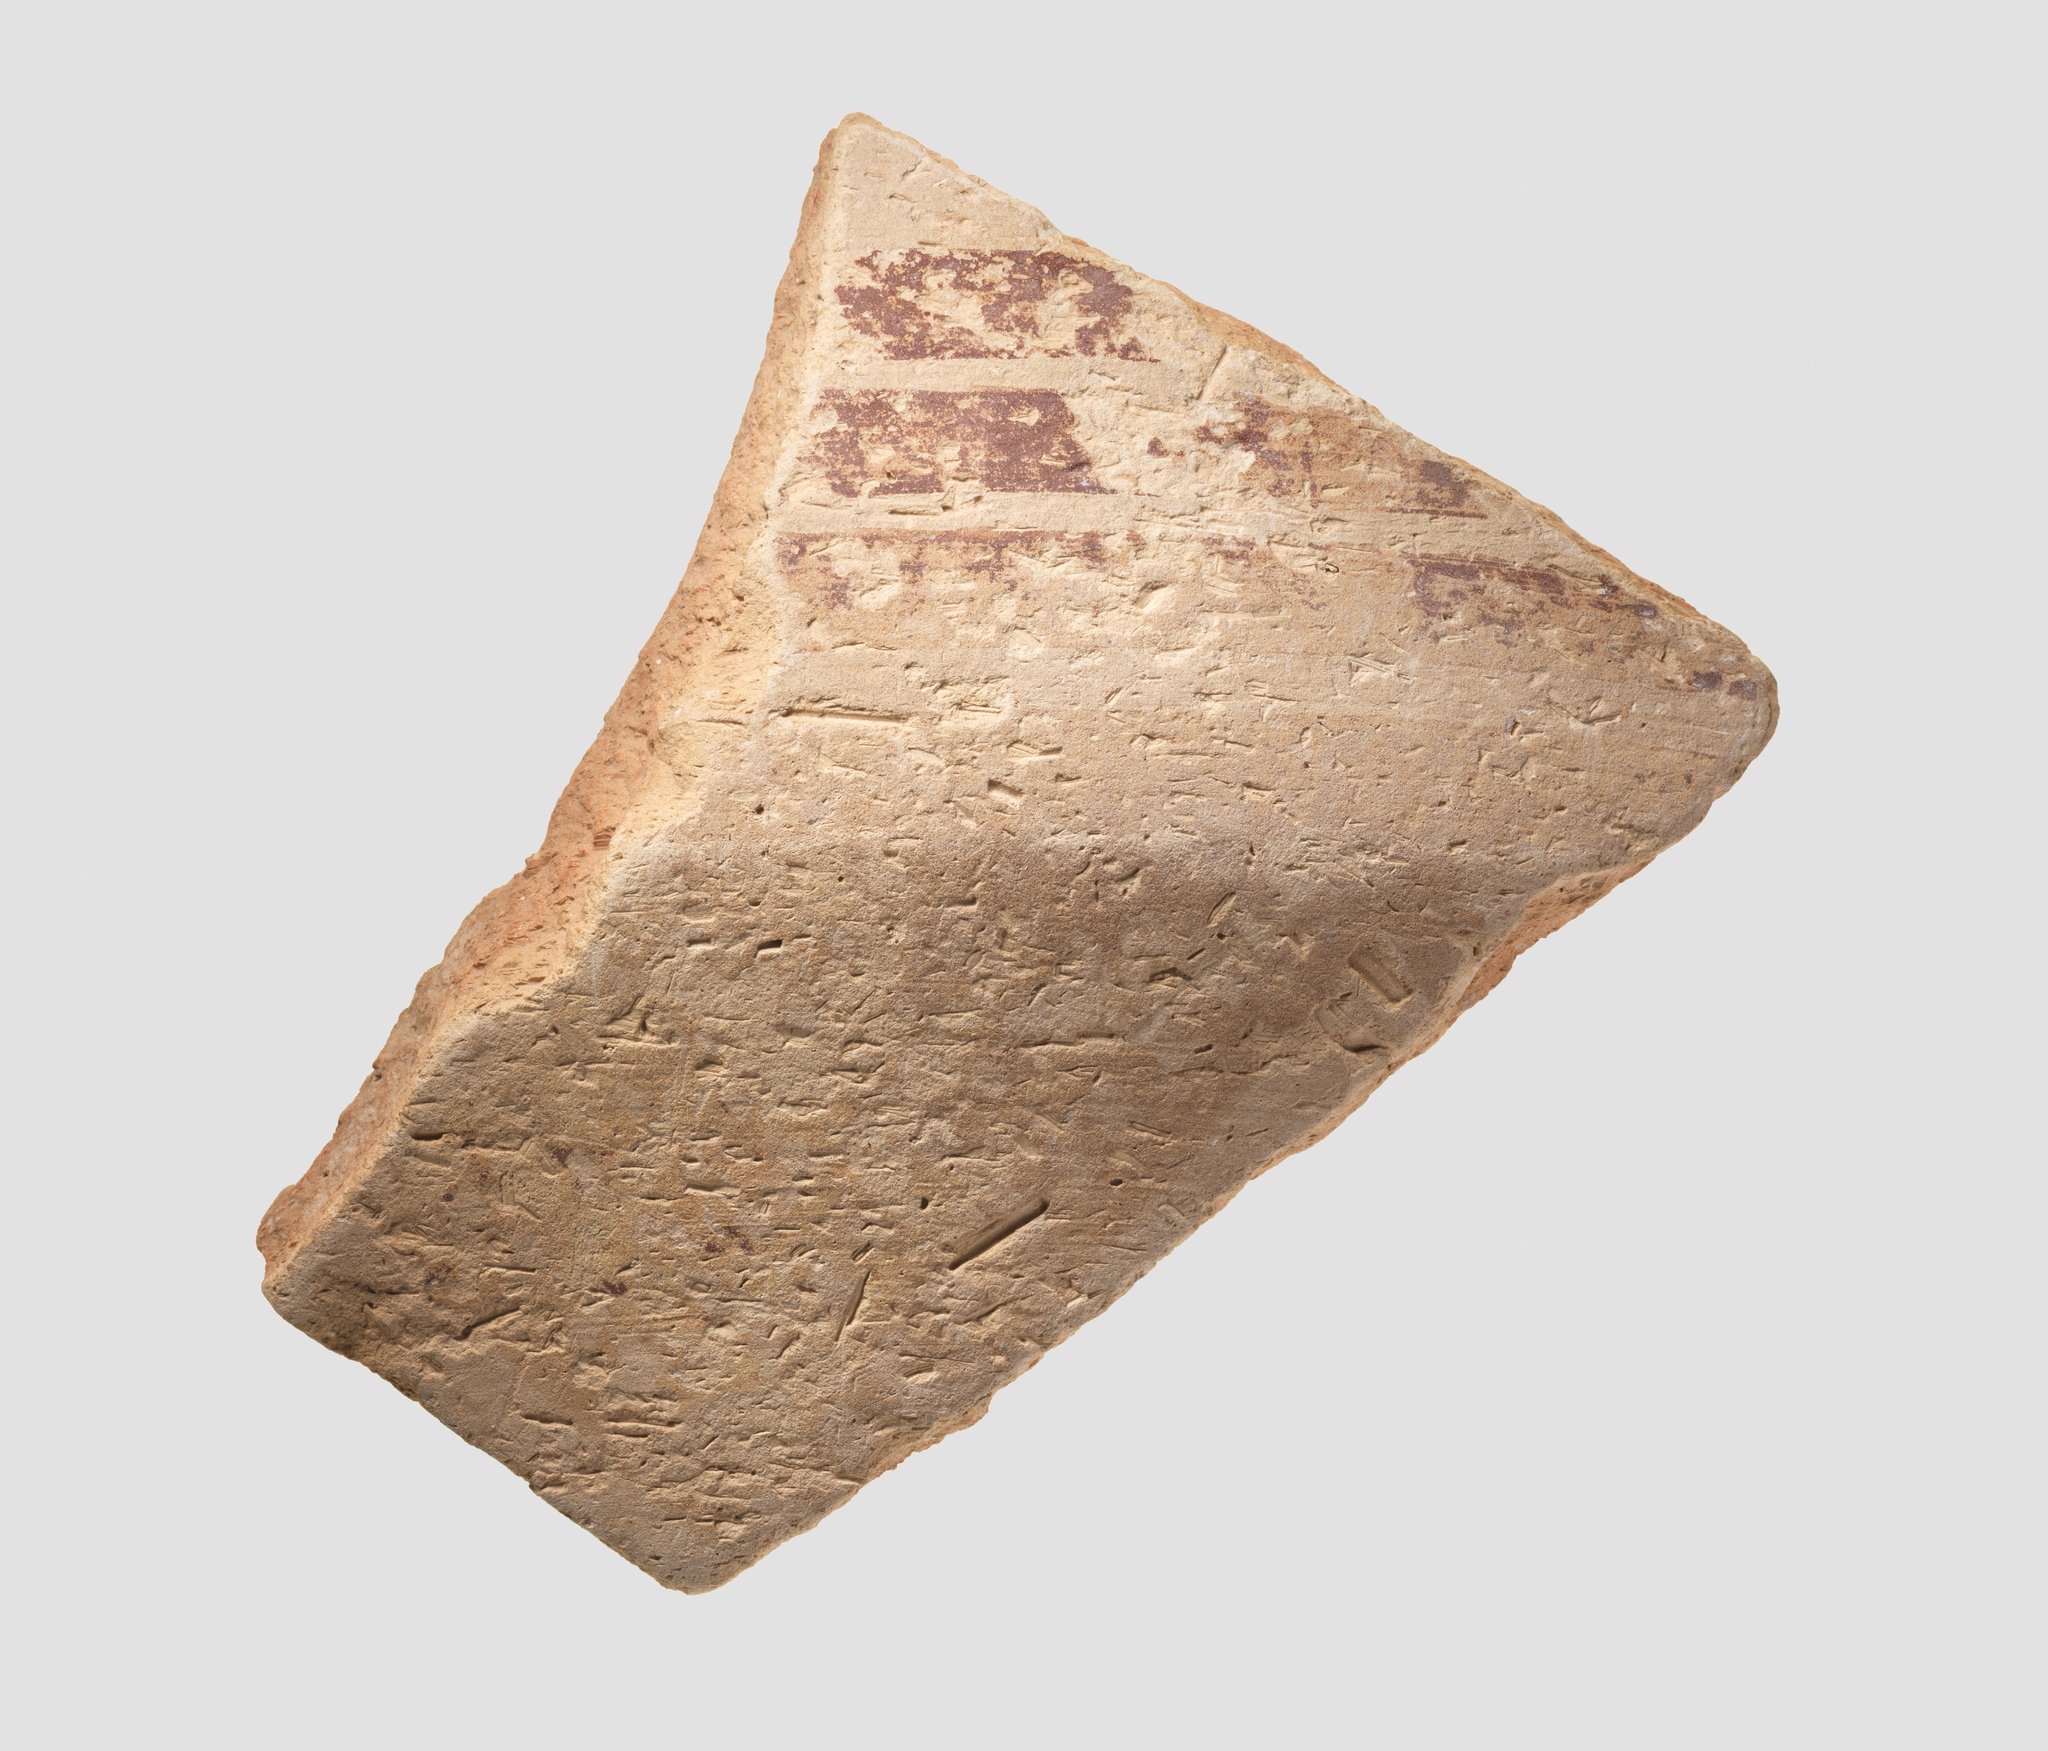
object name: jar or bowl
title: Carinated jar or bowl sherd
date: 2000-1668 BCE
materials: ceramic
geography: mesopotamia